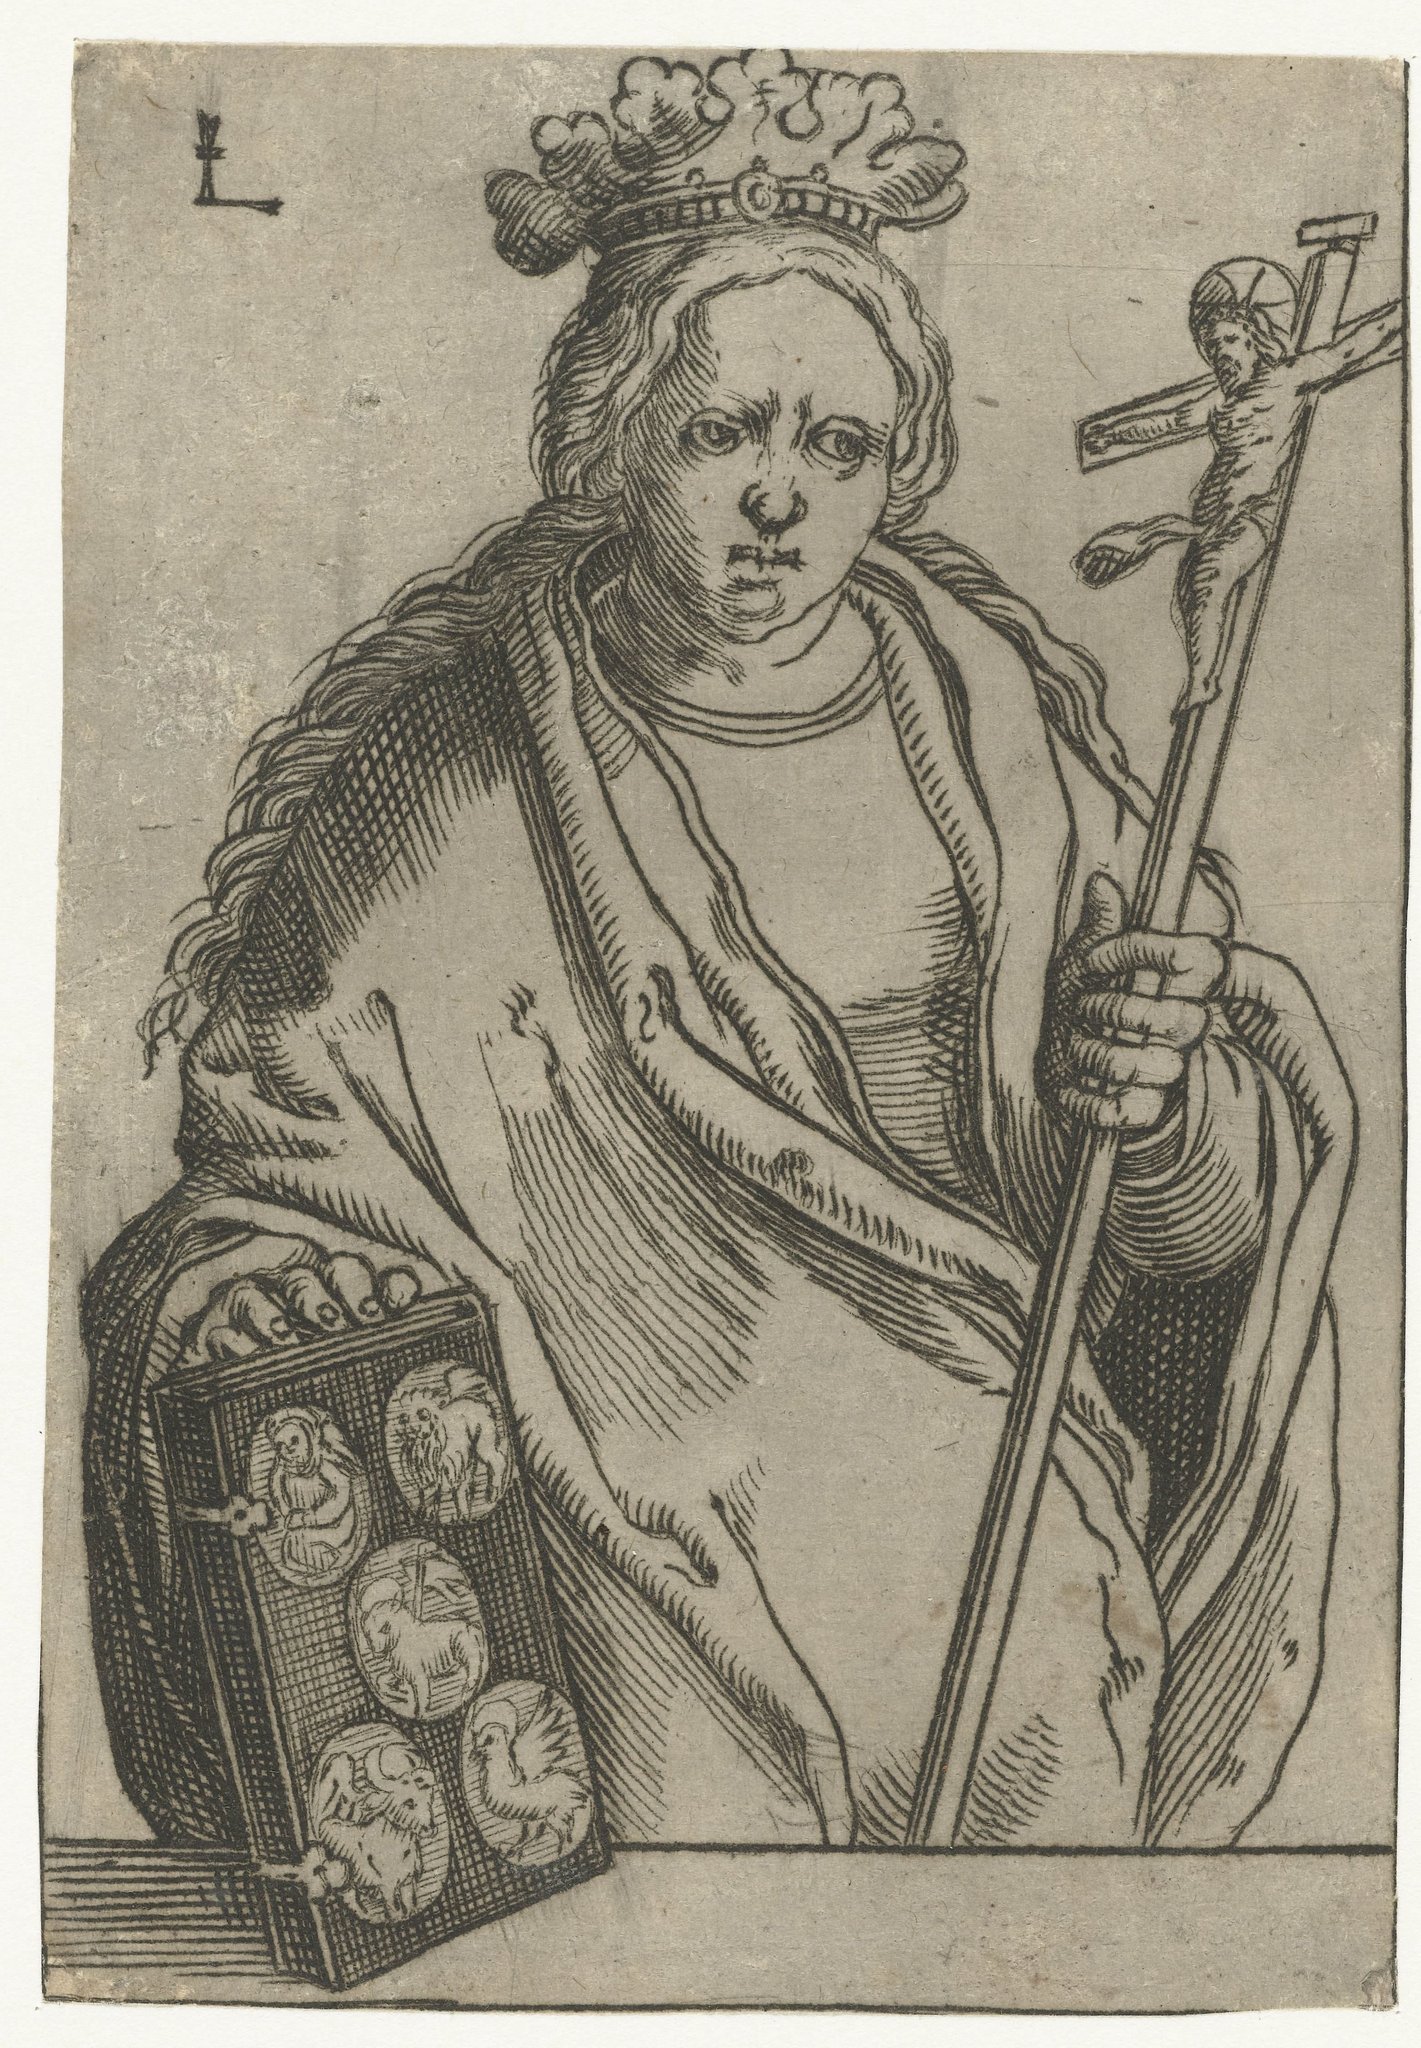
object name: print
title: Personificatie van het Chistelijke Geloof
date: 1528-1583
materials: paper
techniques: engraving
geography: low countries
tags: faith, 'fides'; 'fede', 'fede catholica', 'fede christiana', 'fede christiana catholica' (ripa) ~ one of the three theological virtues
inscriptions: collector's mark: Lugt 240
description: Kopie naar houtsnede, in spiegelbeeld. Vrouw met Nieuwe Testament en staf met crucifix.